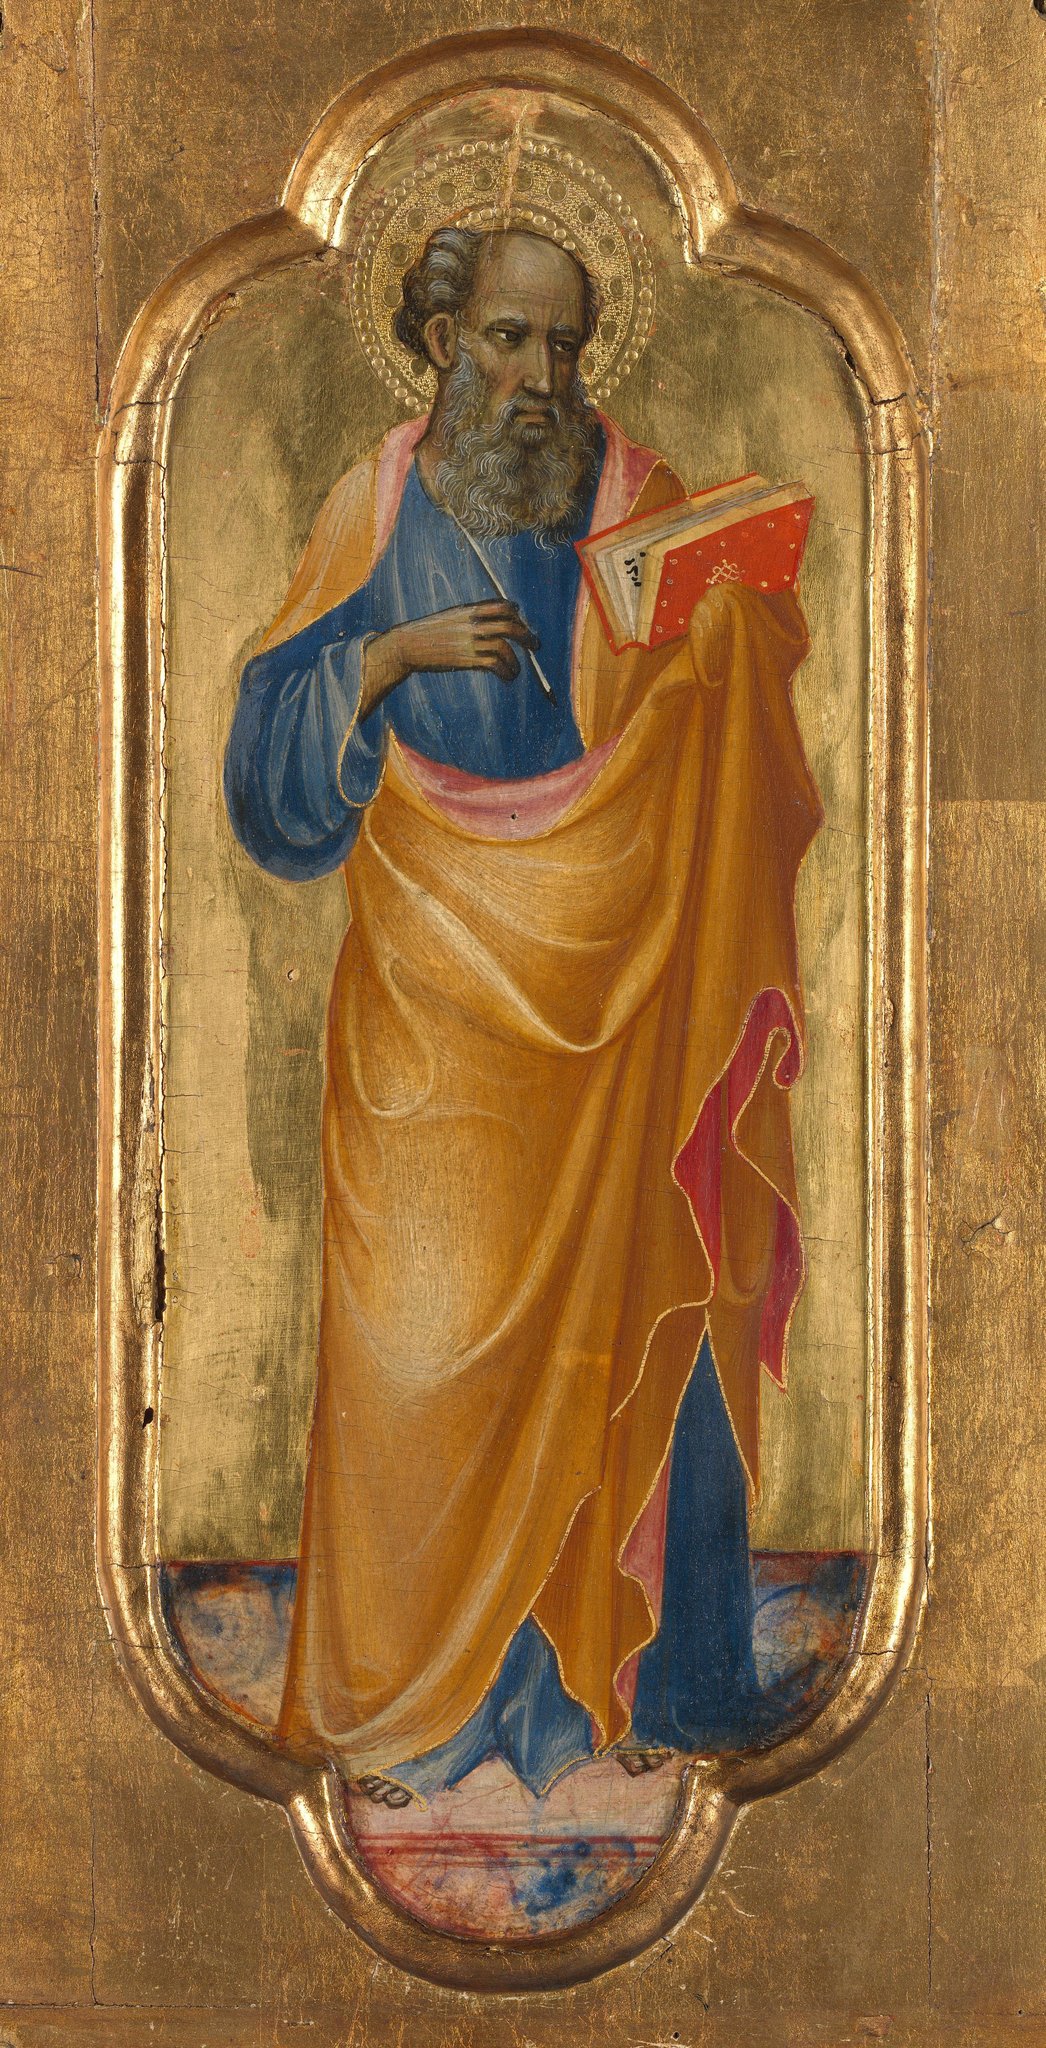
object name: painting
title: Two Evangelists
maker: gherardo starnina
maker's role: painter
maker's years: 1360-1413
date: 1407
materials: paint, panel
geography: florence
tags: evangelists, usually with books or scrolls (not in biblical context)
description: Starnina was a widely travelled artist who developed an elegant and highly coloured style in Spain. After he returned to Florence in 1403, his work exerted a profound influence on the artistic development of Lorenzo Monaco and other Florentine painters. These two panels, which are in excellent condition, probably served as wings of a large altarpiece.